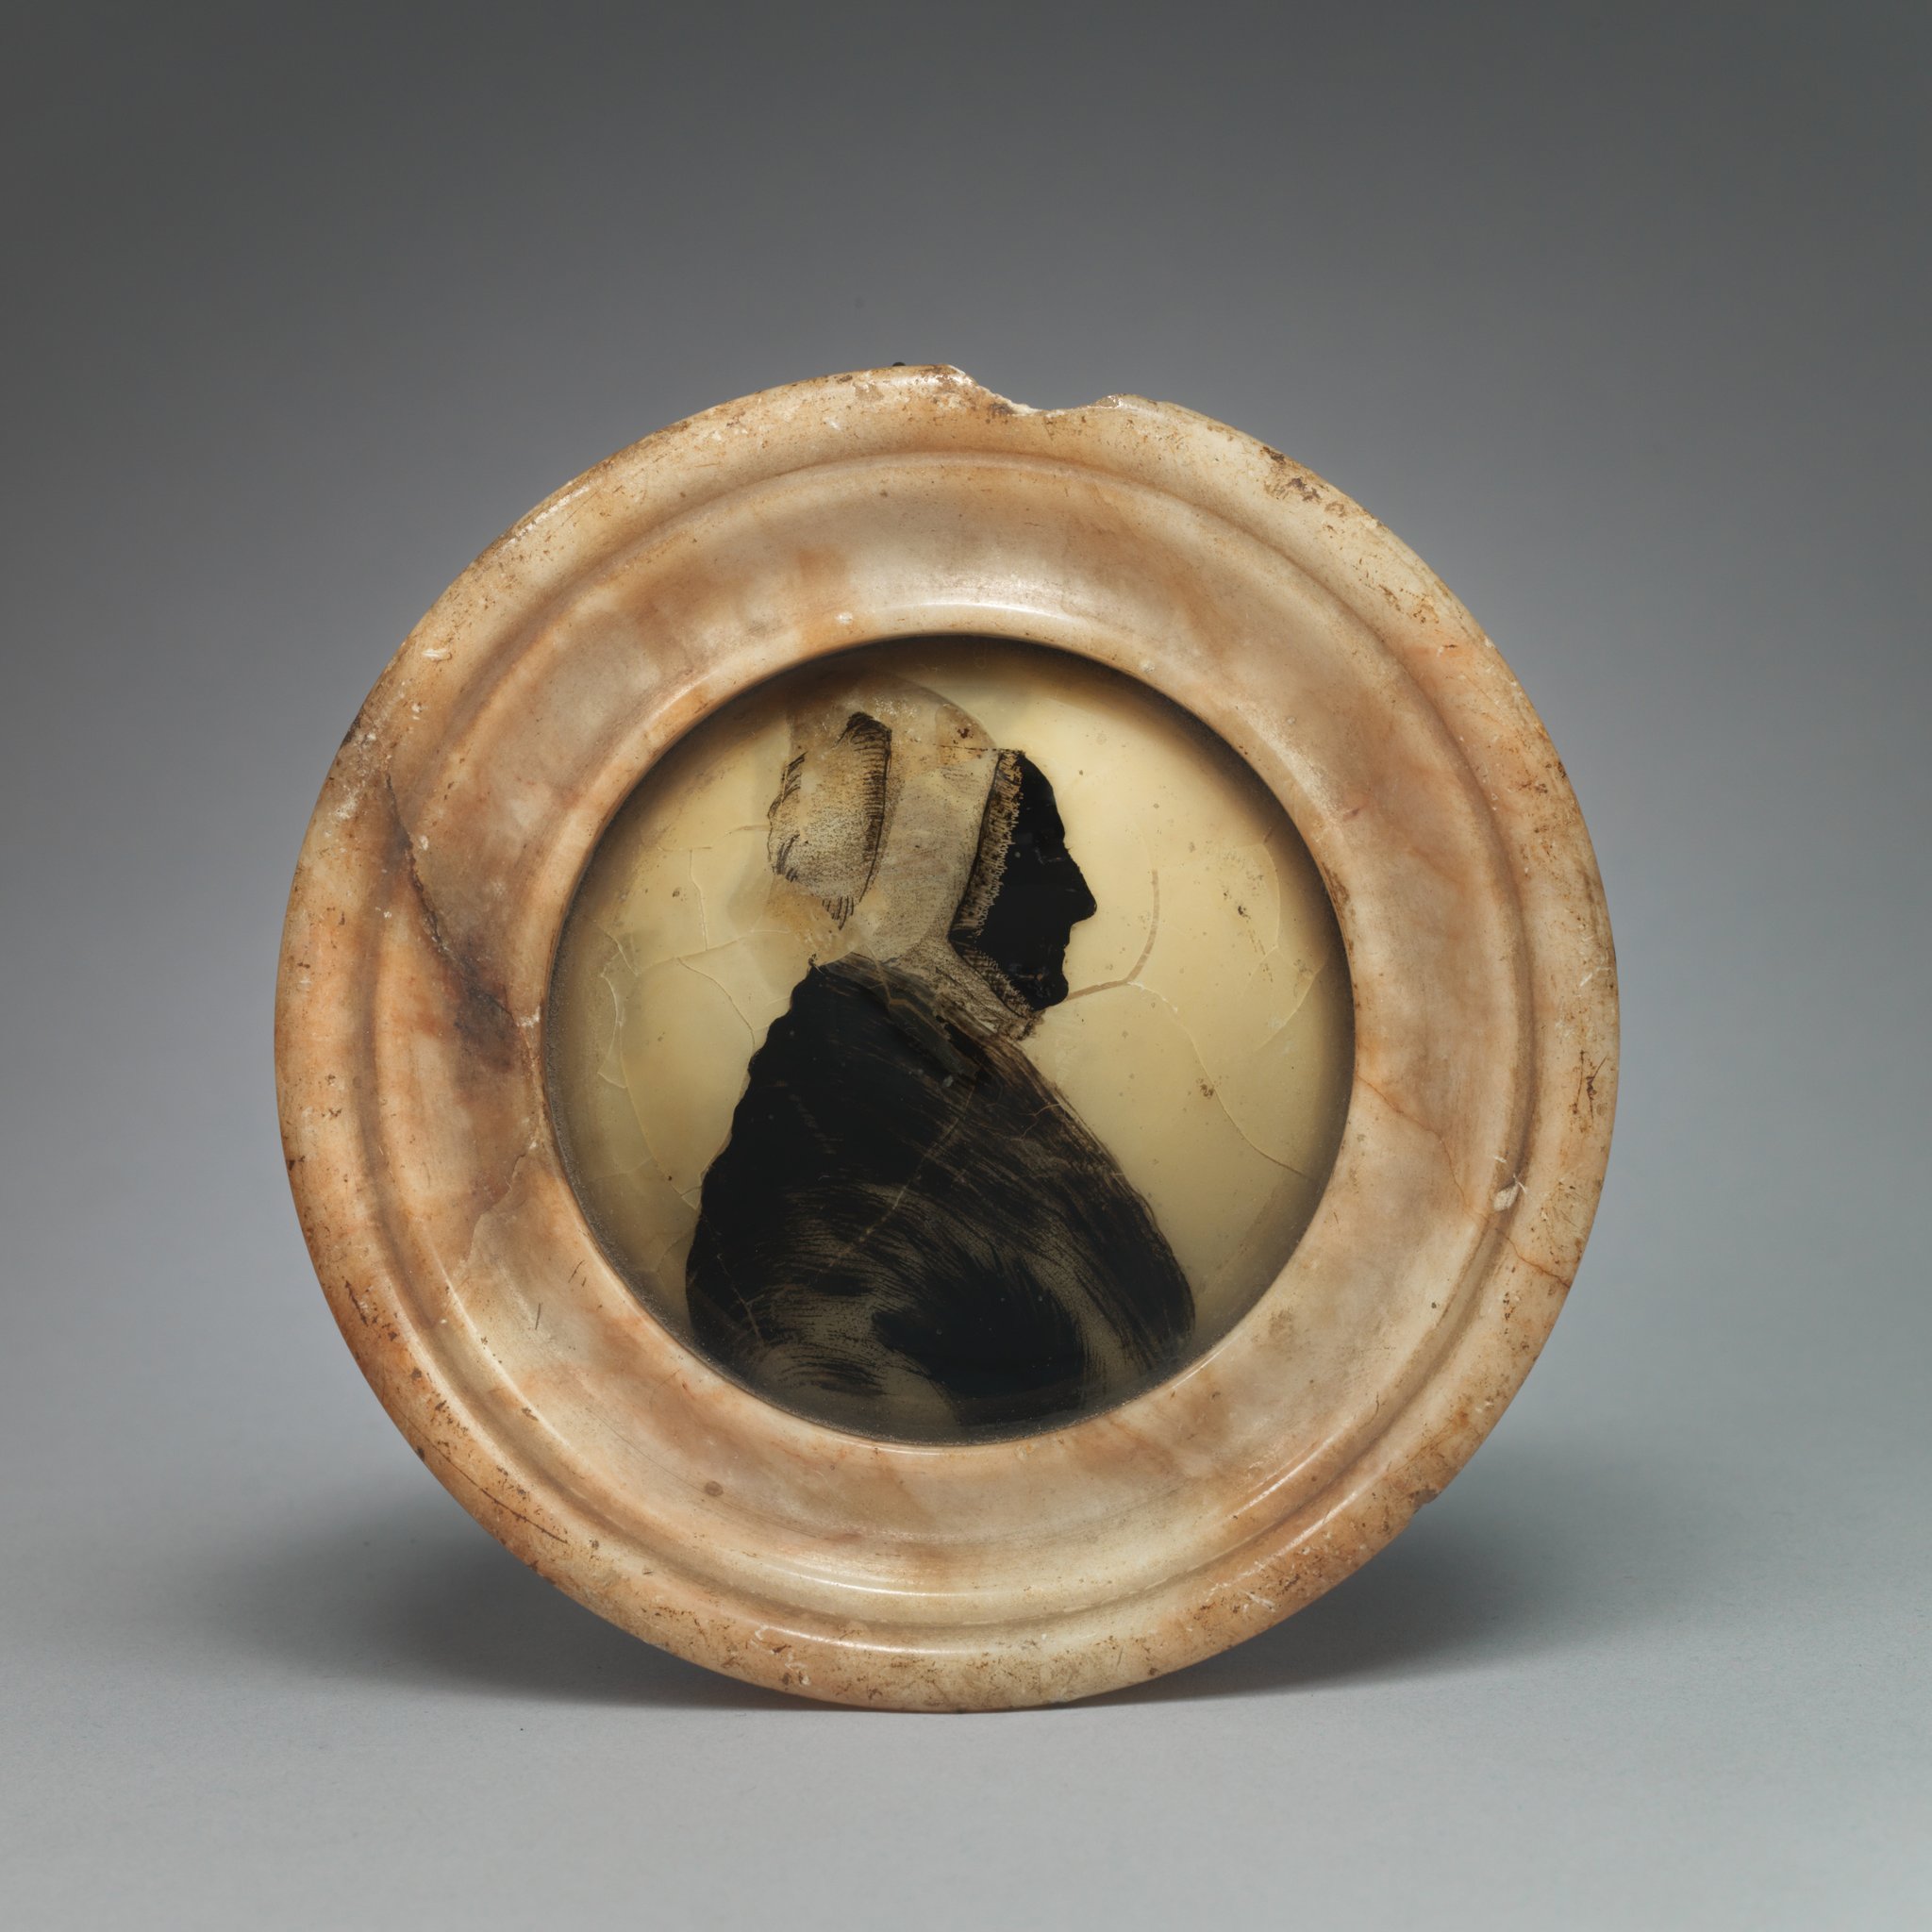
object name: medallion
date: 1801-1900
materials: glass, wax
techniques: painting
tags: profiles,women